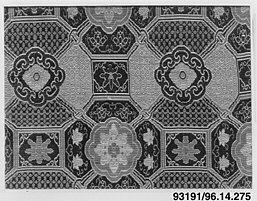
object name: piece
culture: japanese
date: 1701-1900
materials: silk